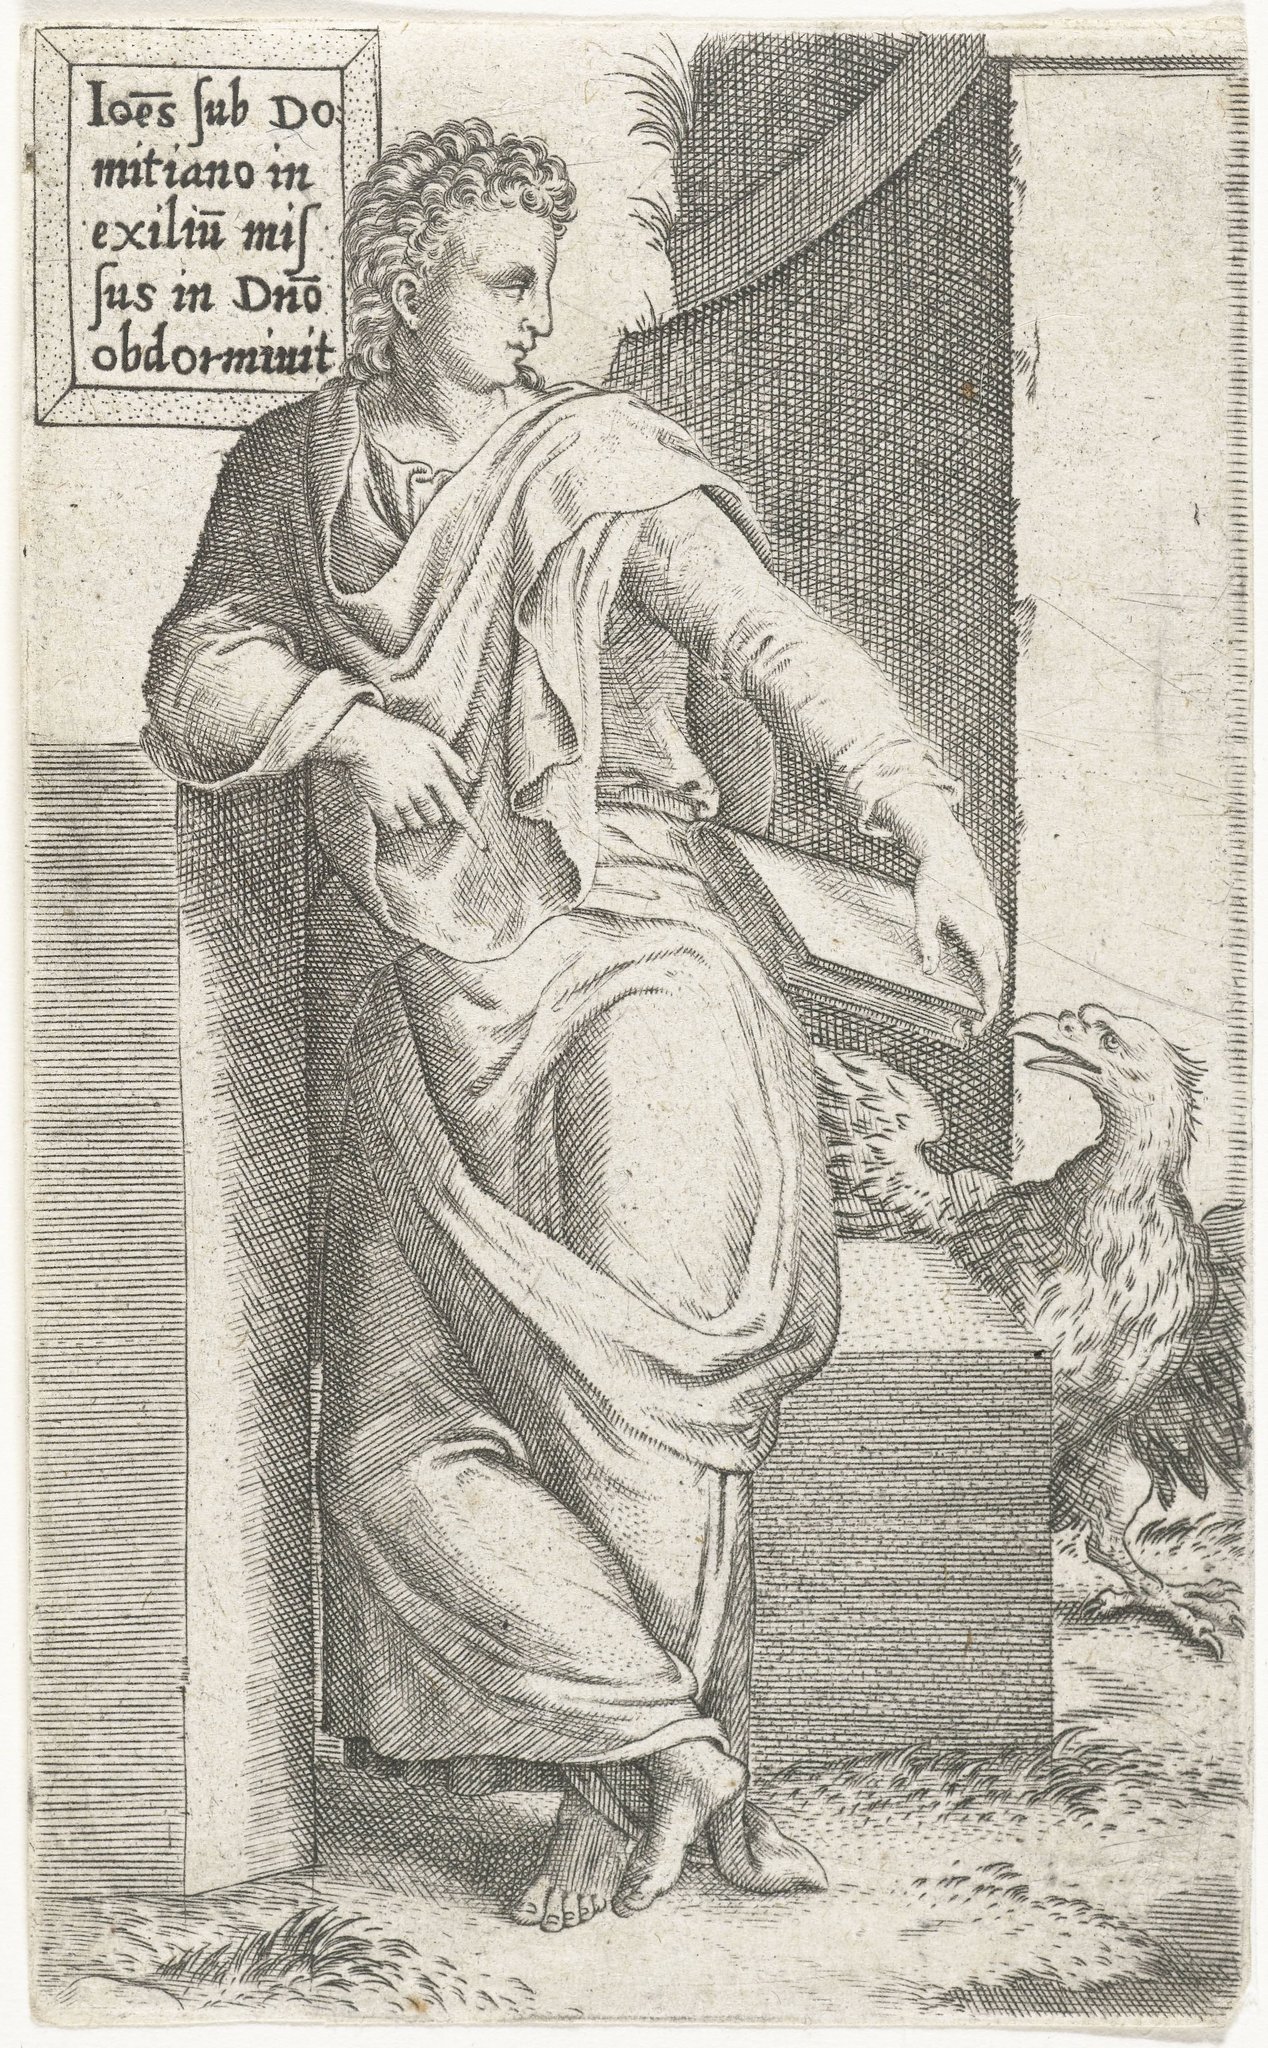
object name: print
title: De vier evangelisten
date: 1530-1580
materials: paper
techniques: engraving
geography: antwerp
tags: the apostle john the evangelist; possible attributes: book, cauldron, chalice with snake, eagle, palm, scroll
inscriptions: collector's mark: Lugt 2228, collector's mark: Lugt 2760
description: De evangelist Johannes, staand bij ruïne, met boek in linkerhand. naast hem zijn attribuut de adelaar. Linksboven in kader een Latijnse tekst.